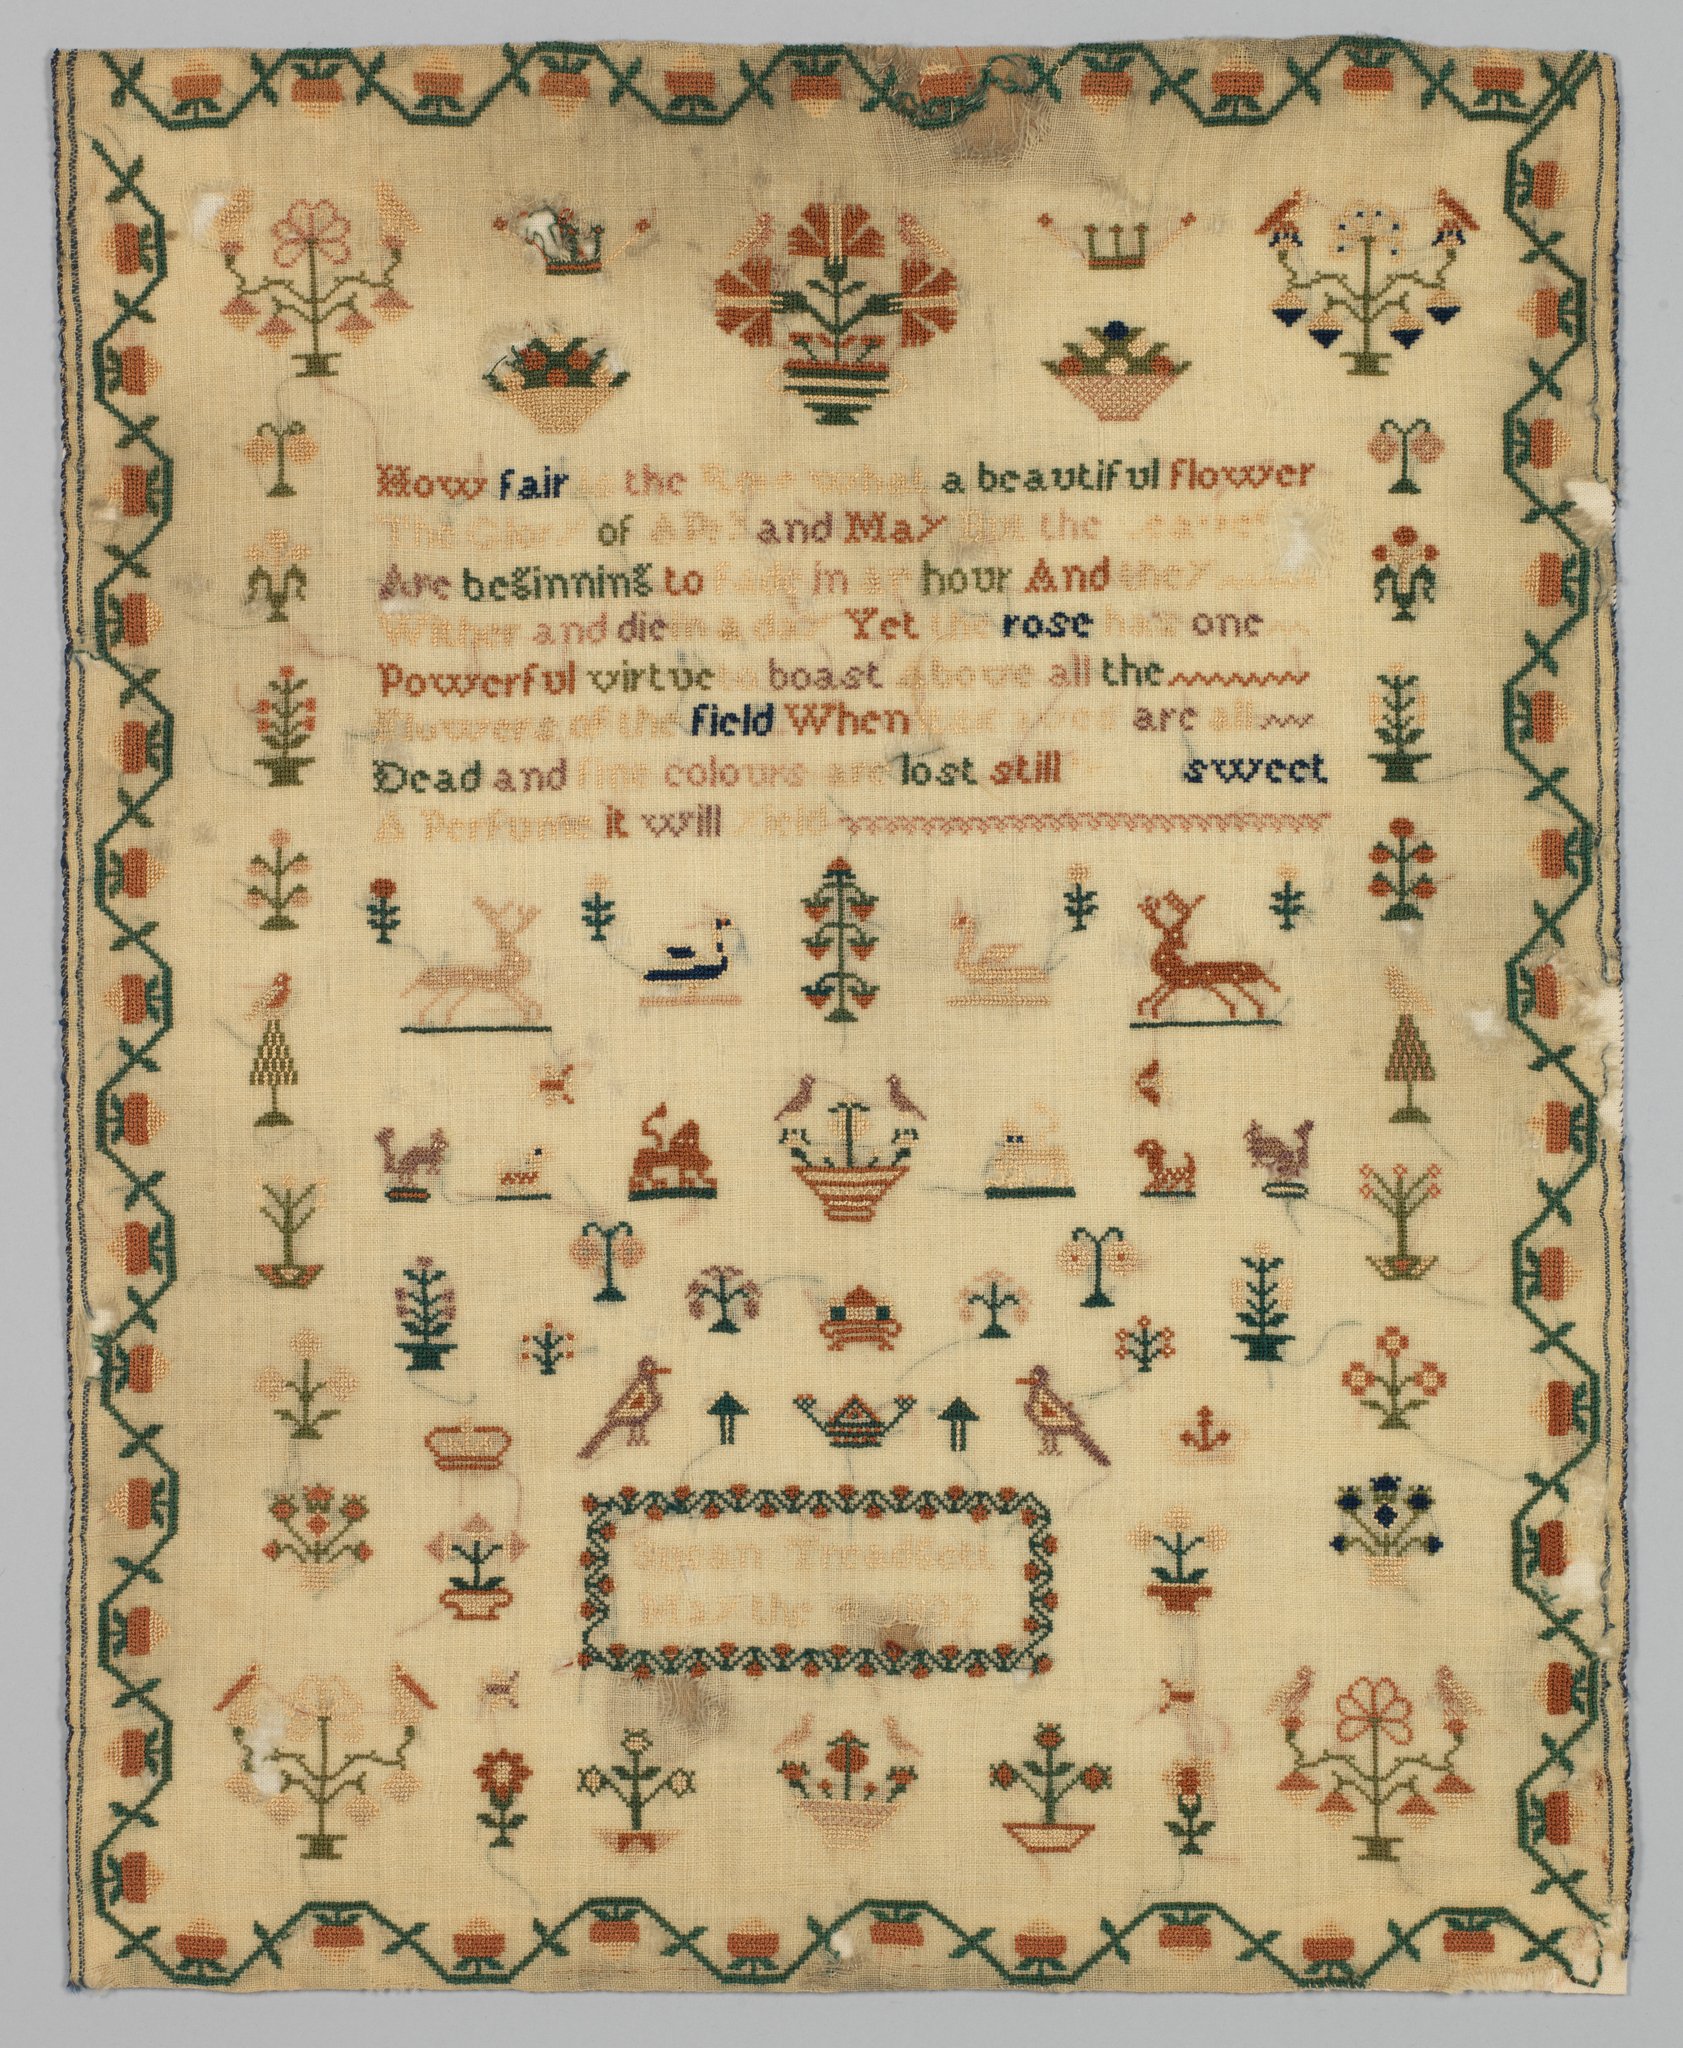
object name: sampler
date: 1832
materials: canvas, silk, wool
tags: birds,deer